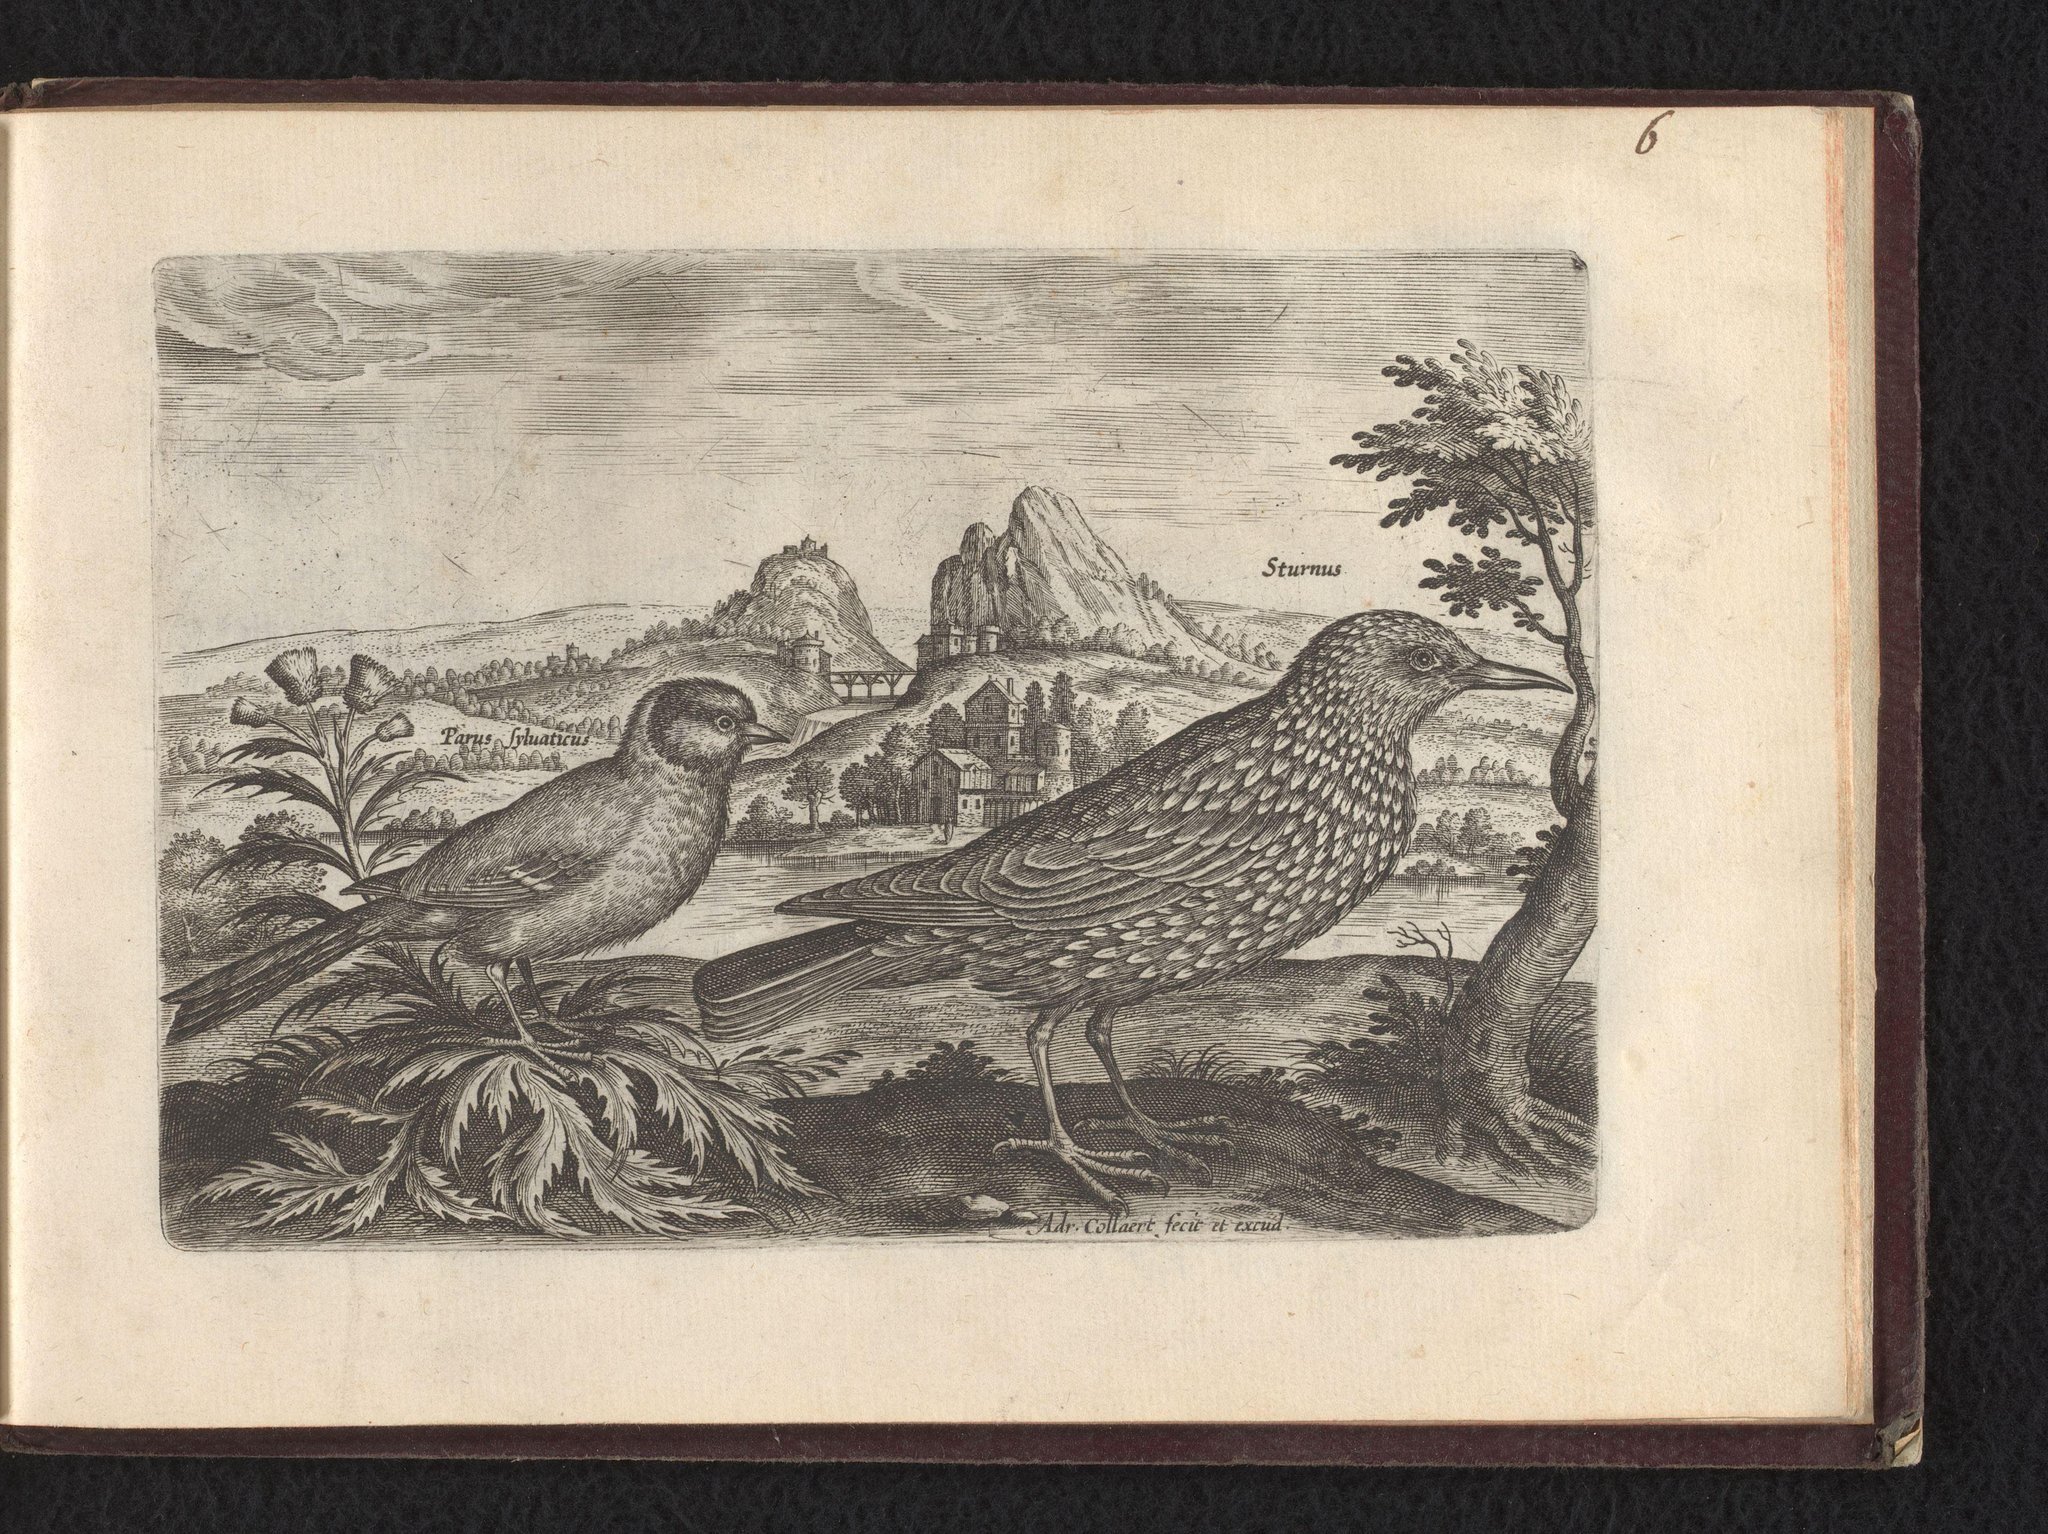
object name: print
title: Avium Vivae Icones in aes incisae & edita ab Adriano Collardo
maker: adriaen collaert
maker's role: draughtsman, print maker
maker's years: 1560-1618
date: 1600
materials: paper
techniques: engraving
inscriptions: signature and address: ‘Adrian Collaert fecit et excud.’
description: Koolmees en spreeuw, zittend naar rechts. Landschap met heuvels op achtergrond.